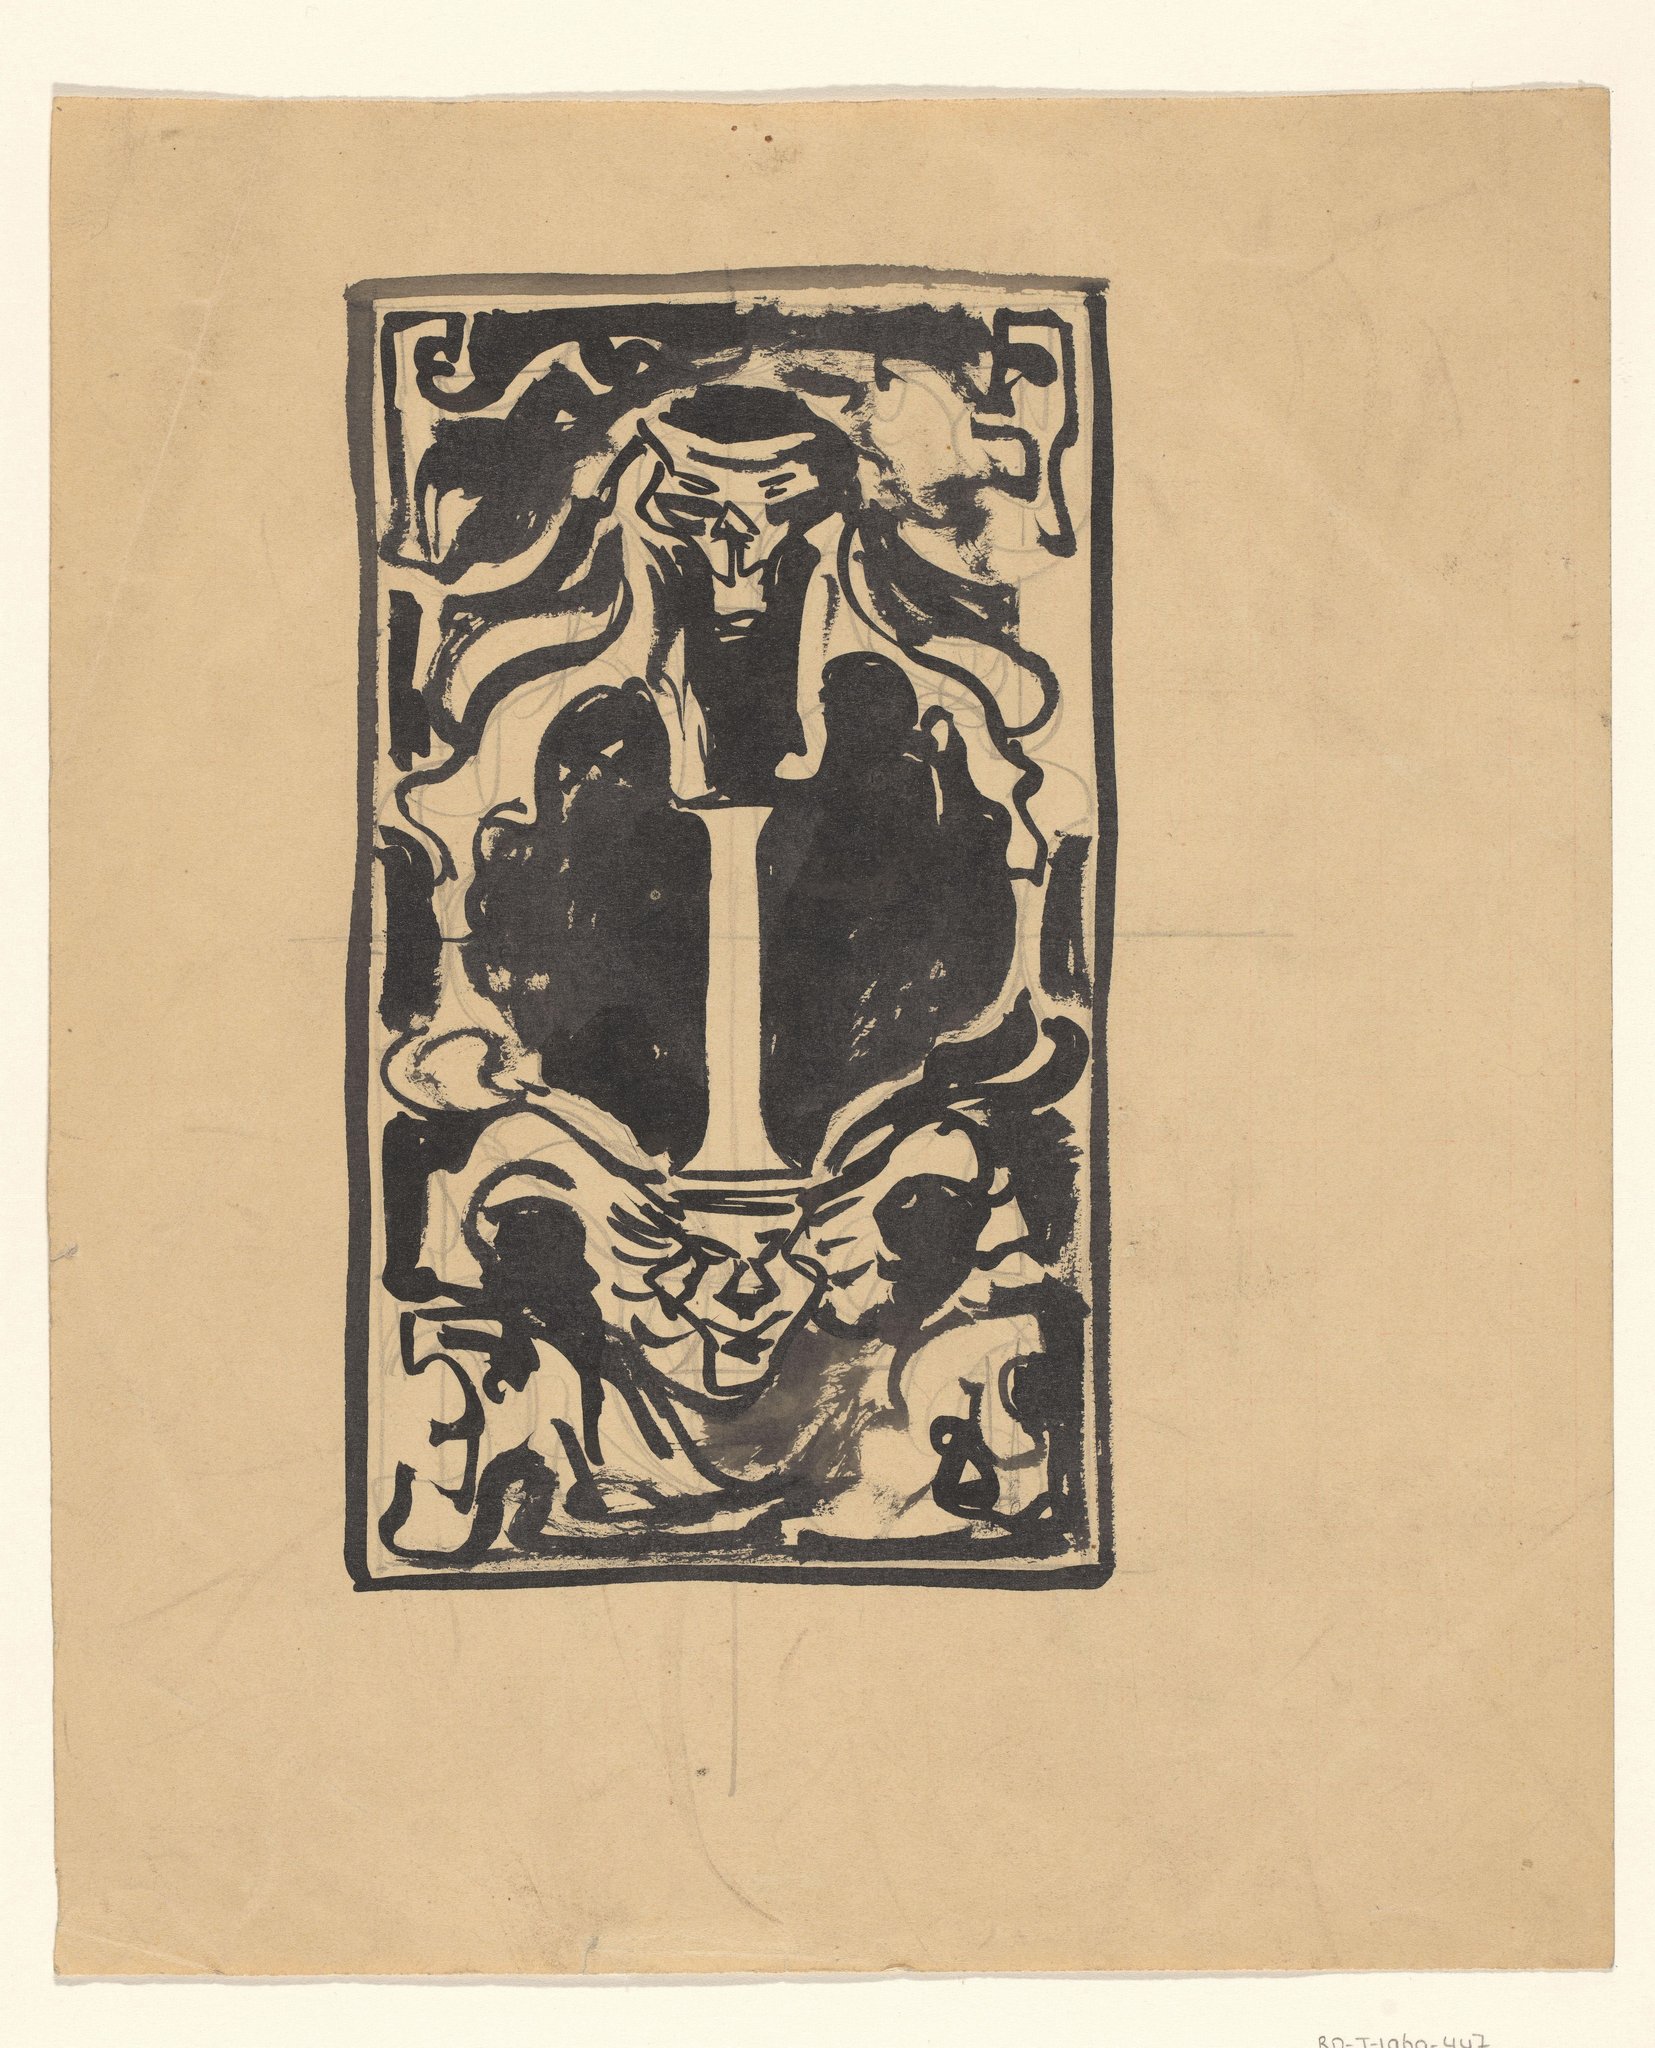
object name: drawing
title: Decoratief ontwerp met leeuwen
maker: carel adolph lion cachet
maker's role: draughtsman, print maker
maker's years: 1864-1945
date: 1874-1945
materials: pencil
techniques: brush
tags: ornament derived from animal forms, beasts of prey, predatory animals: lion